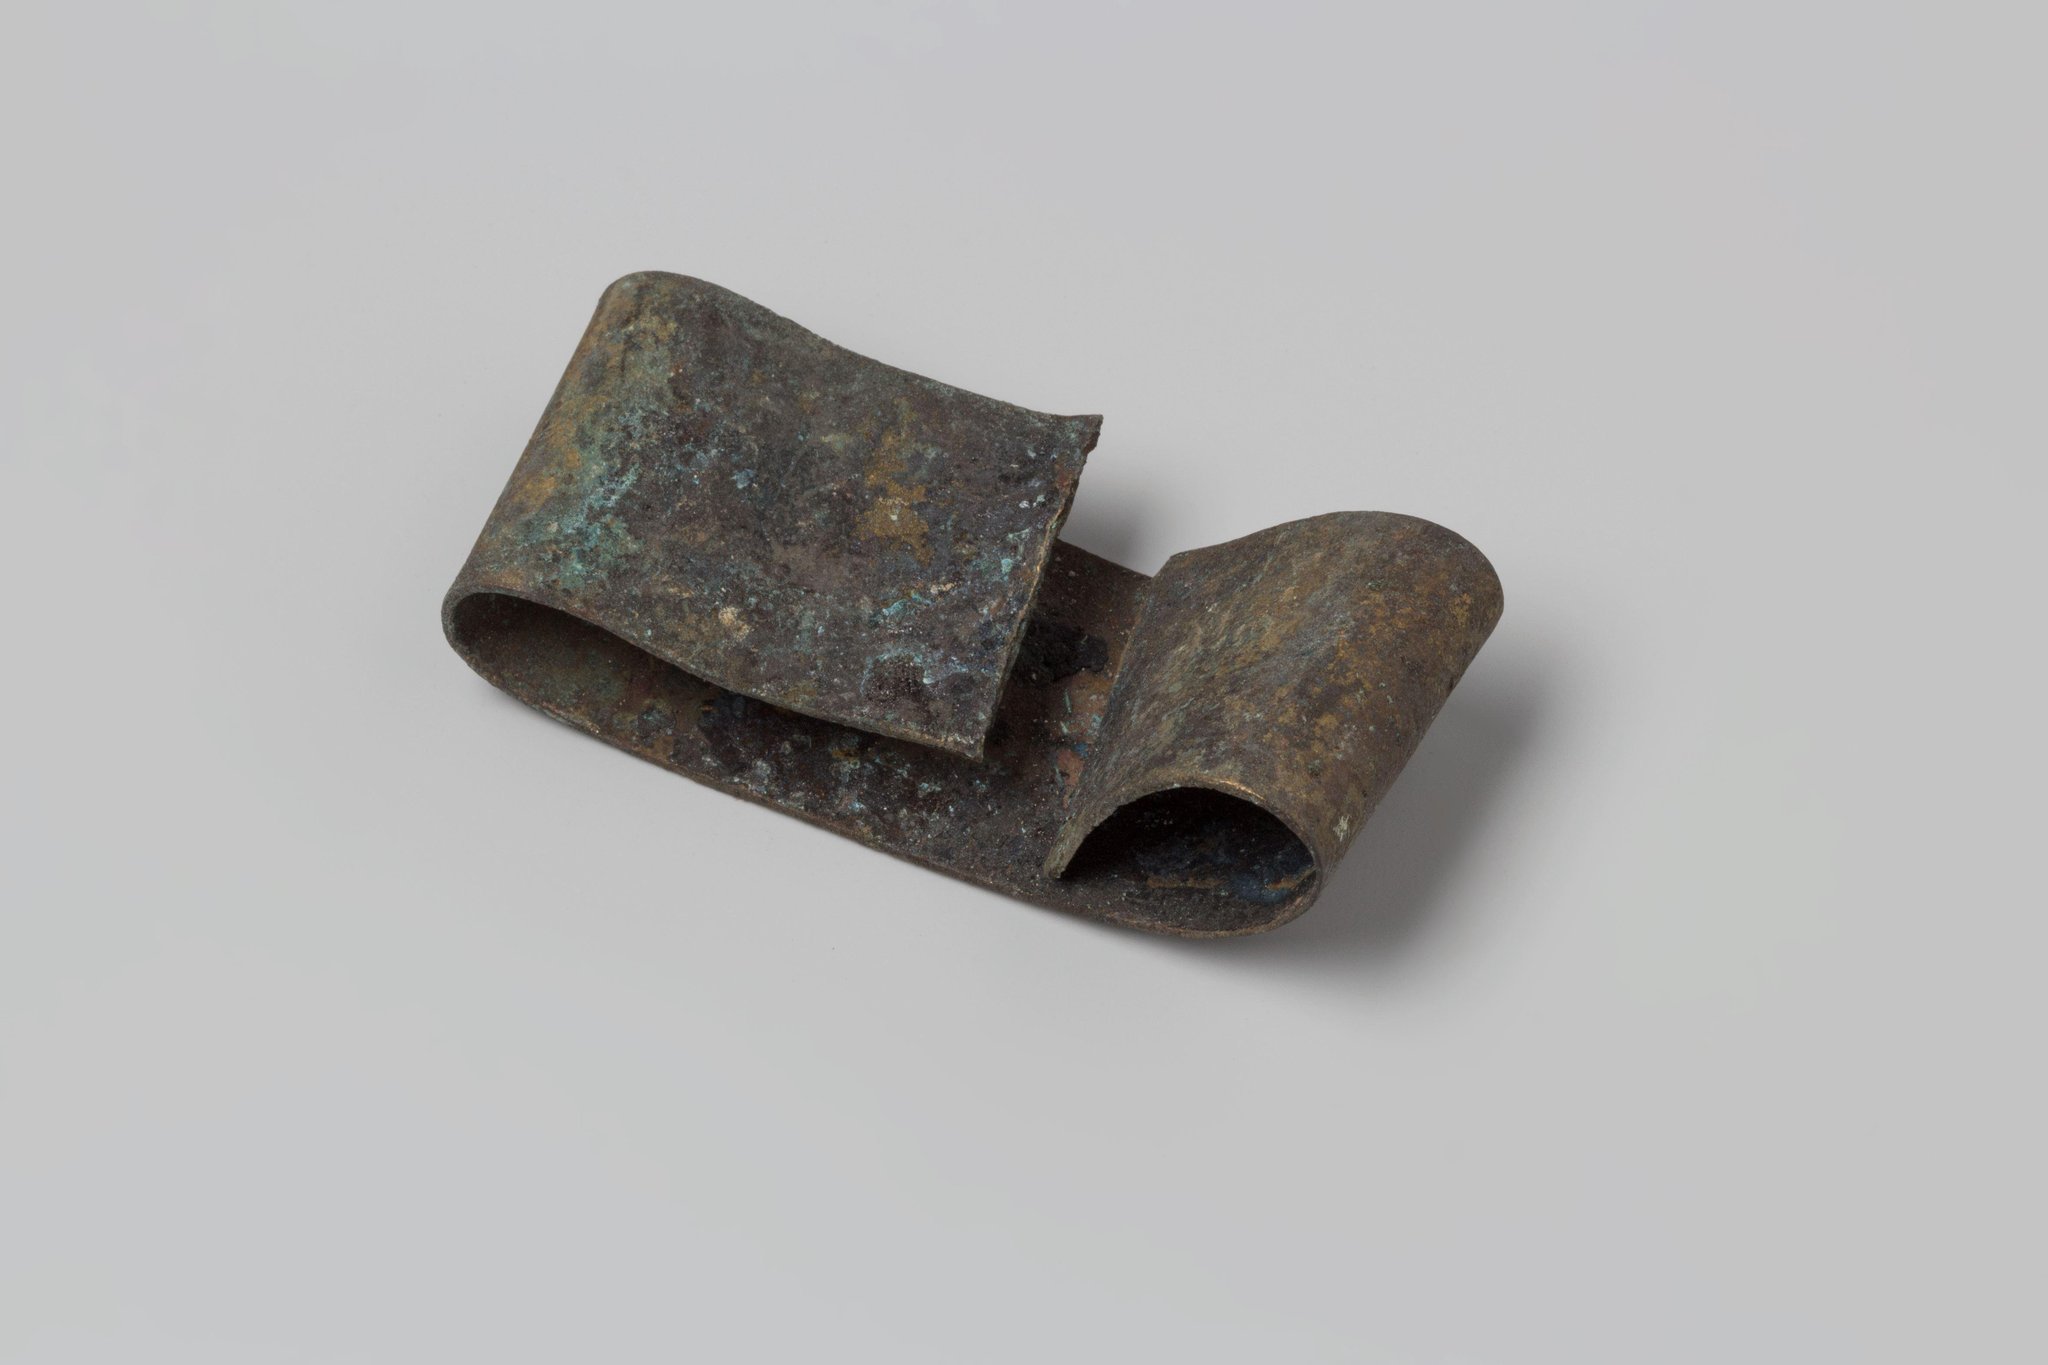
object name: firehose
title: Fragment van brandslangring uit het wrak van de Oost-Indiëvaarder Hollandia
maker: Anonymous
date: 1700-1743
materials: copper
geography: netherlands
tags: verenigde oostindische compagnie, hollandia (schip), annet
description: Fire engine, firehose; fragments, id. NG-1975-20-H-1271-a, squashed.